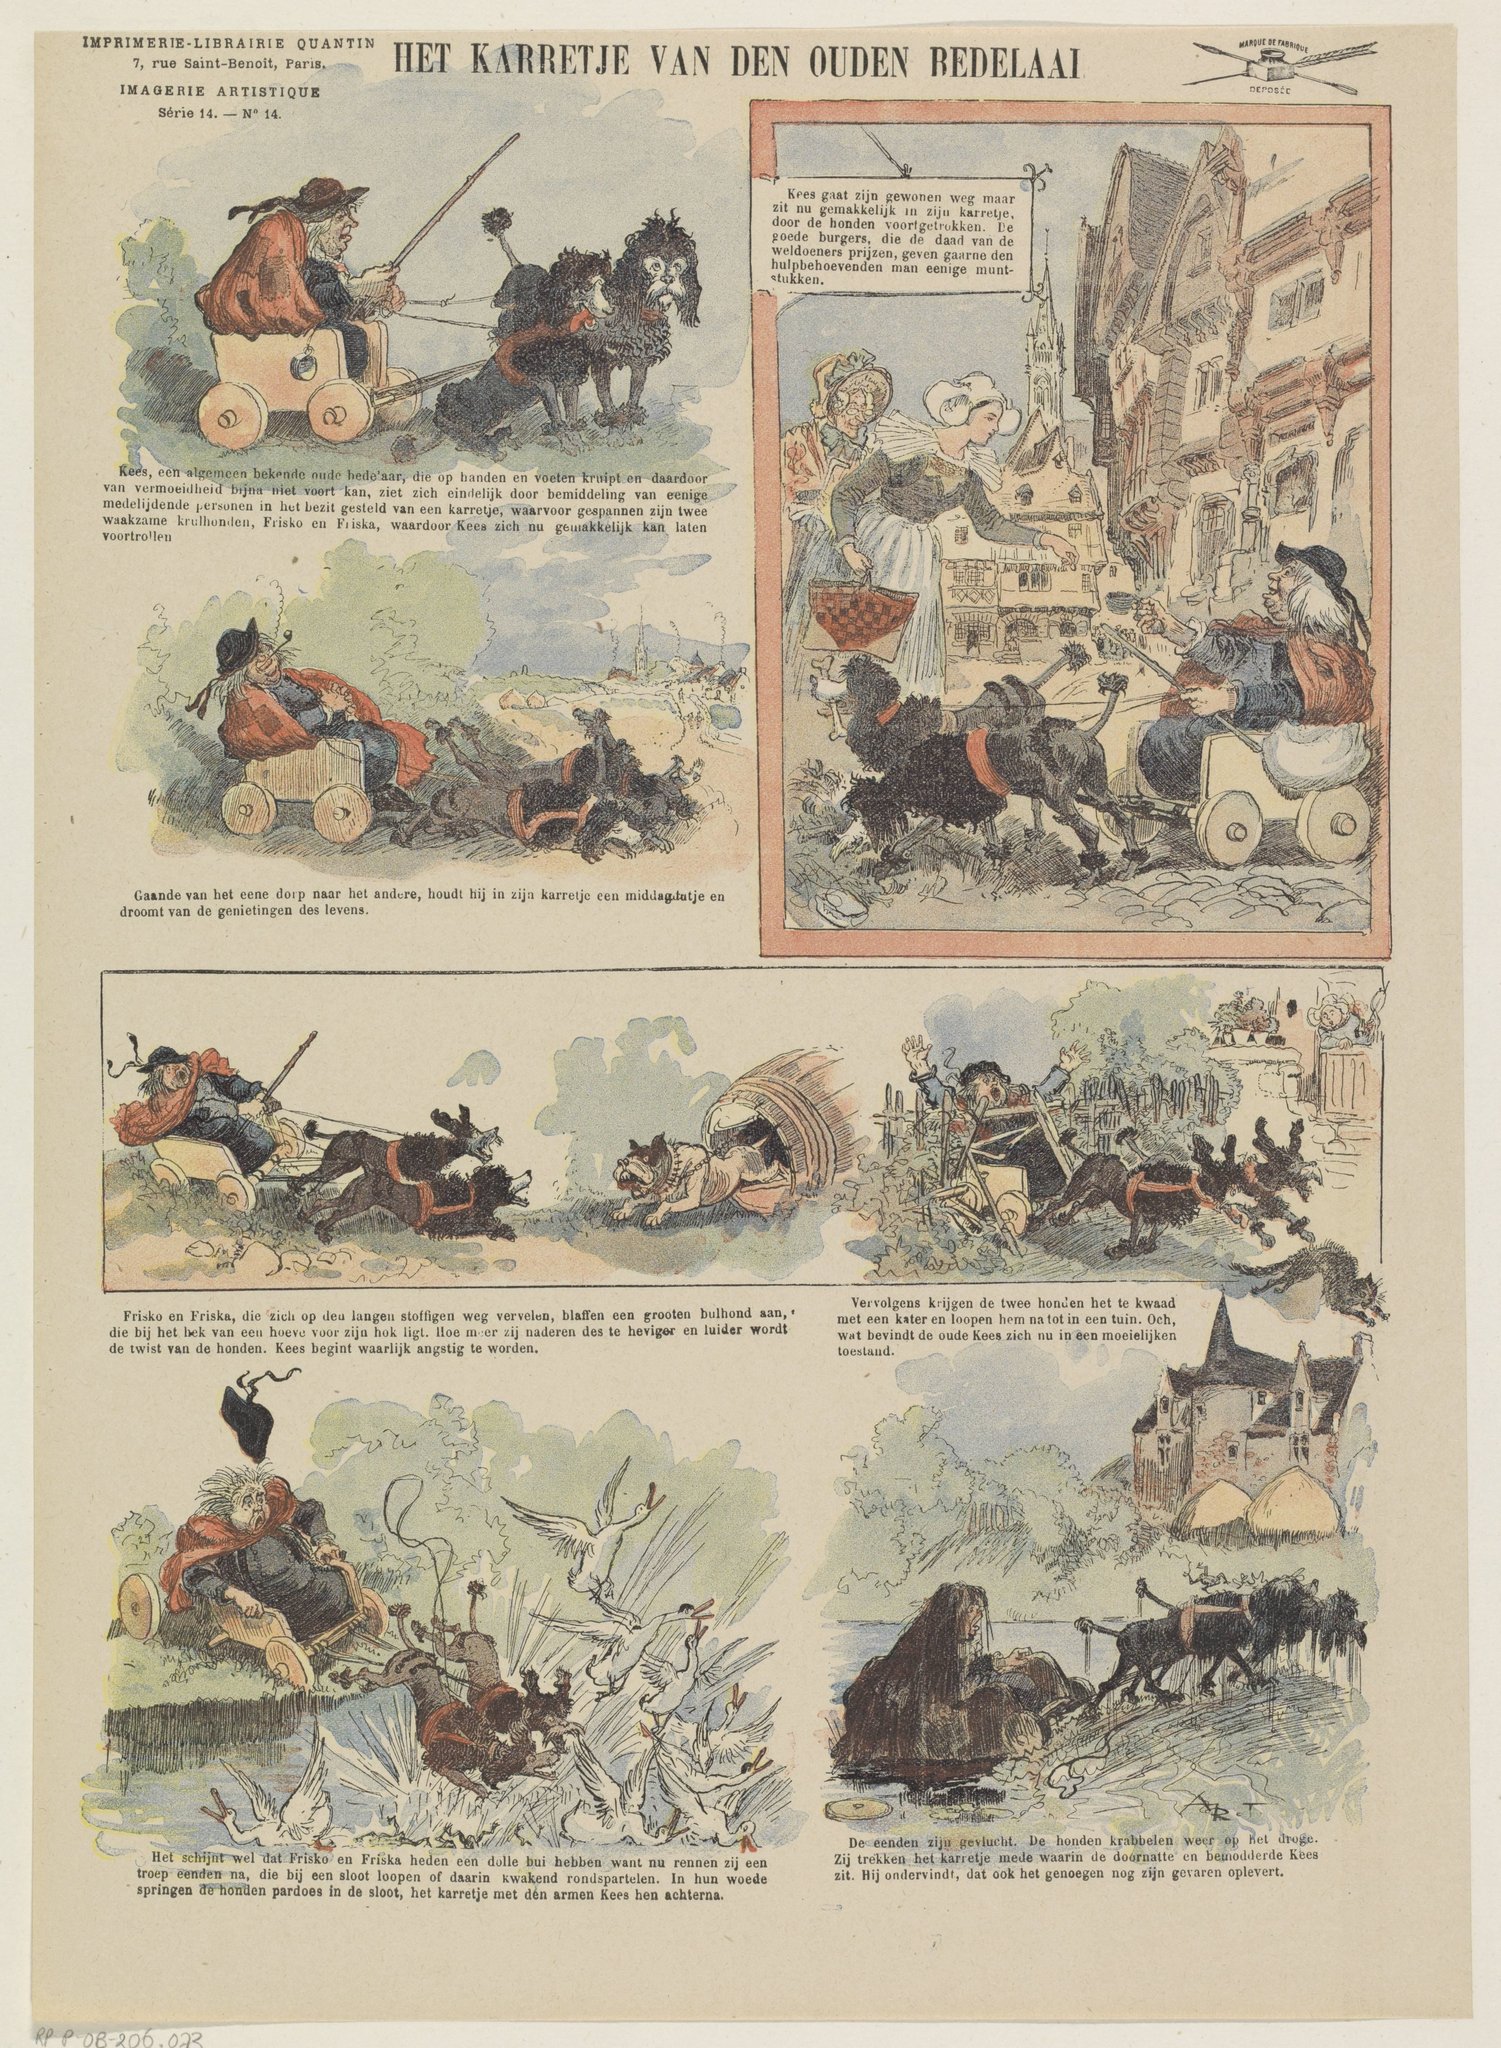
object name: print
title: Een karretje van den ouden bedelaar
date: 1876-1890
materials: paper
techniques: lithograph, letterpress printing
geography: paris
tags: tales and fairy tales, beggar, small canal, ditch, dog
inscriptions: collector's mark: Lugt 2760, : ‘marque de fabrique / deposée’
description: Blad met 7 voorstellingen van een bedelaar in een hondekar. De honden rennen achter een kat aan en springen in een sloot met eenden. De bedelaar belandt in de sloot. Onder elke afbeelding een onderschrift. Genummerd linksboven: Série 14. - No. 14.